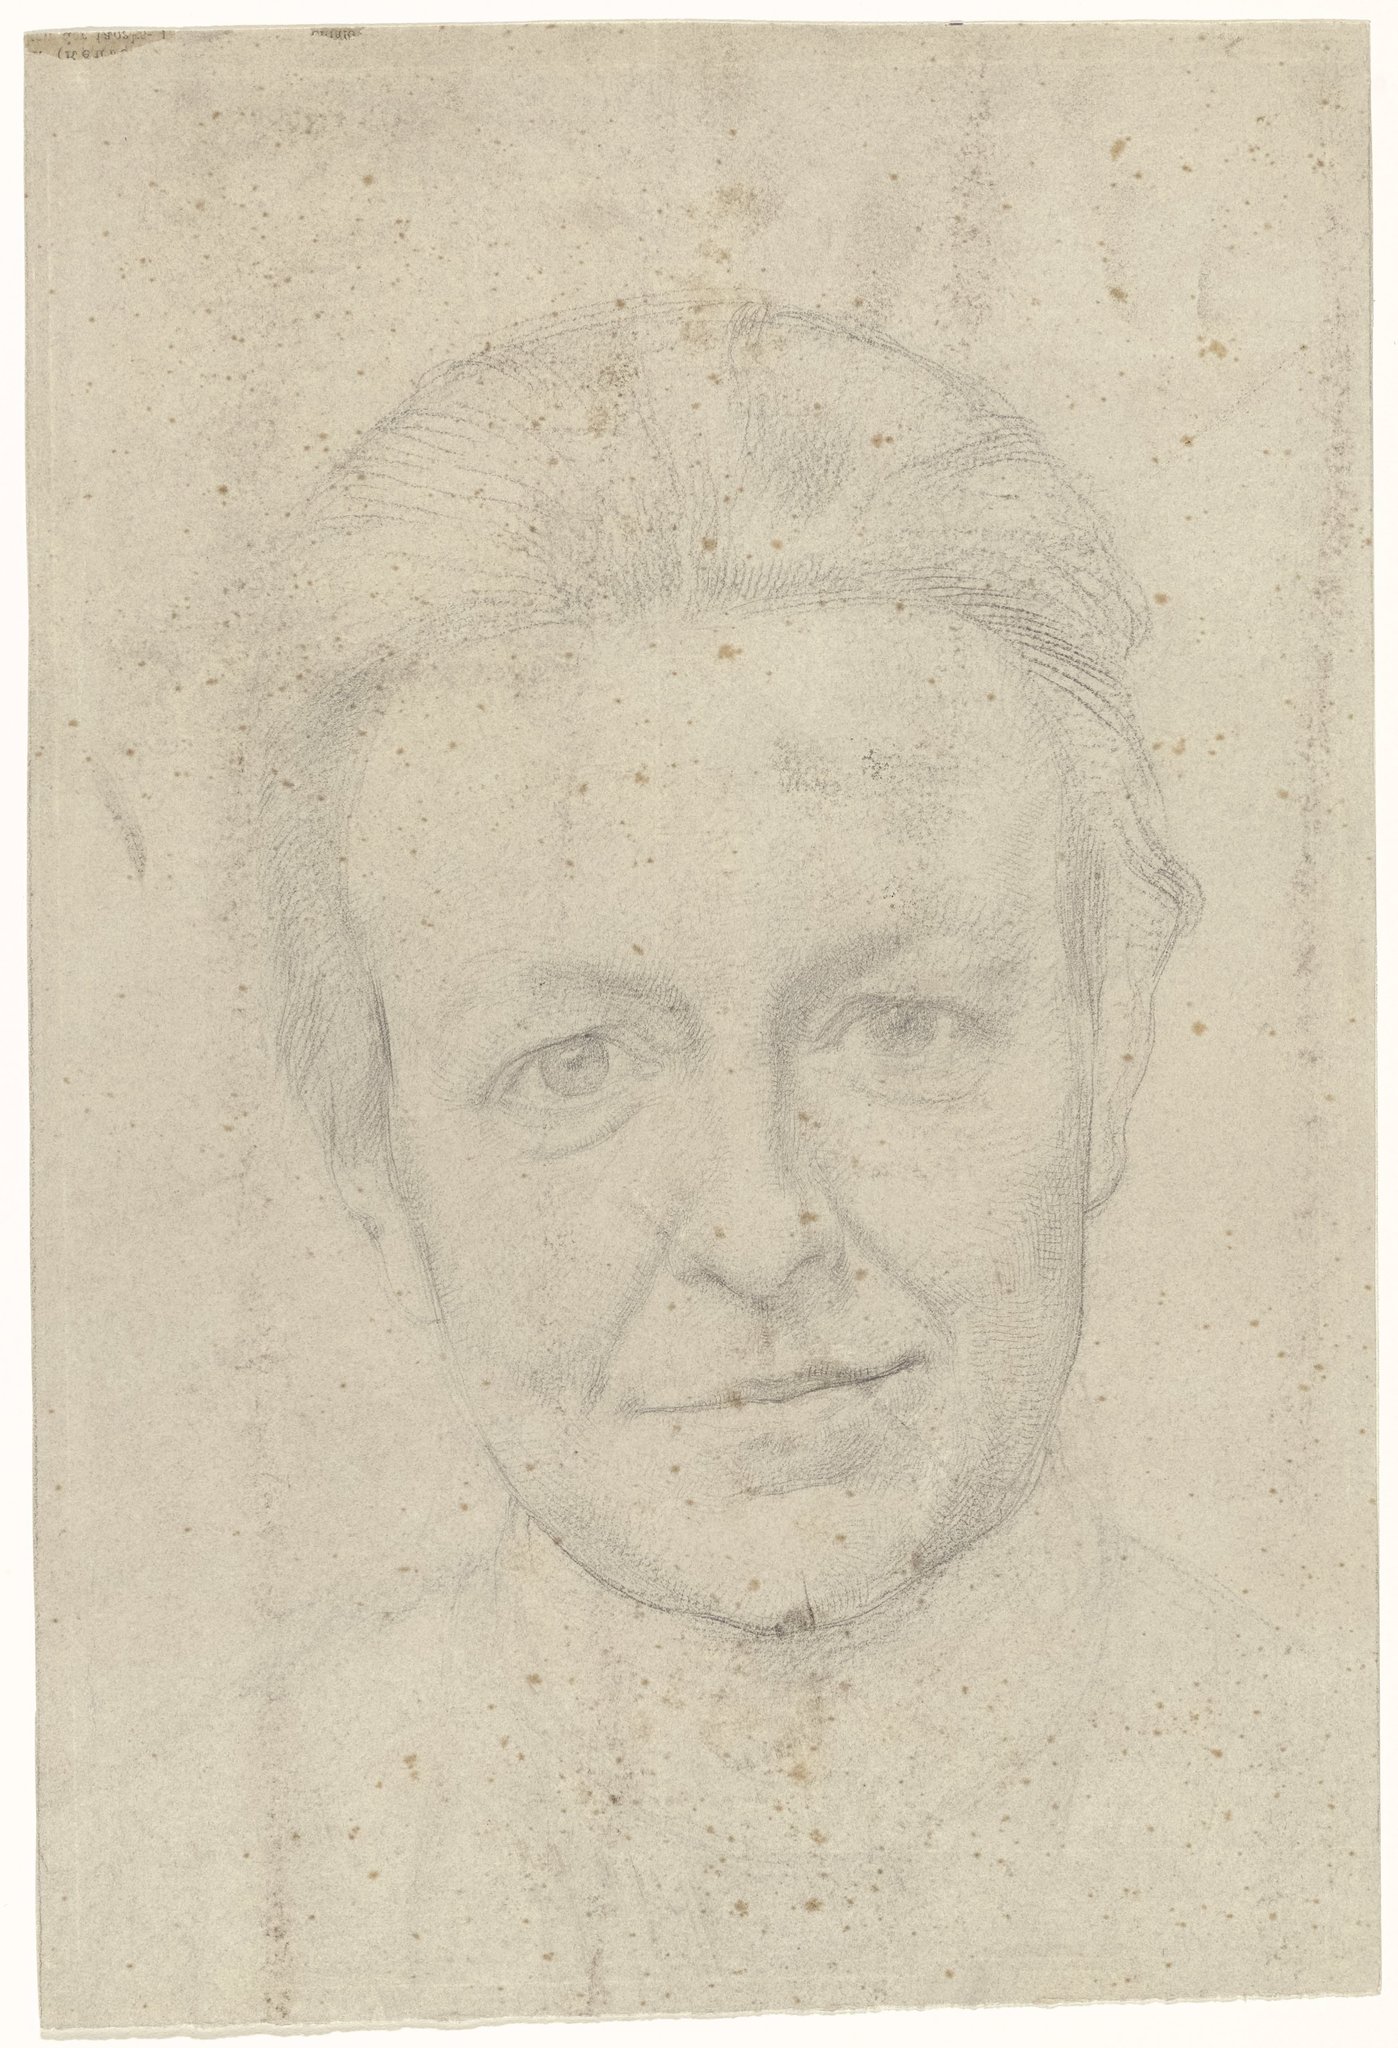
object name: drawing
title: Portret van Mevrouw J.H. Derkinderen-Besier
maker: antoon derkinderen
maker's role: draughtsman, painter, print maker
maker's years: 1859-1925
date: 1869-1925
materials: paper, pencil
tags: utrecht, amsterdam, print maker, johanna henriëtte besier, historical persons